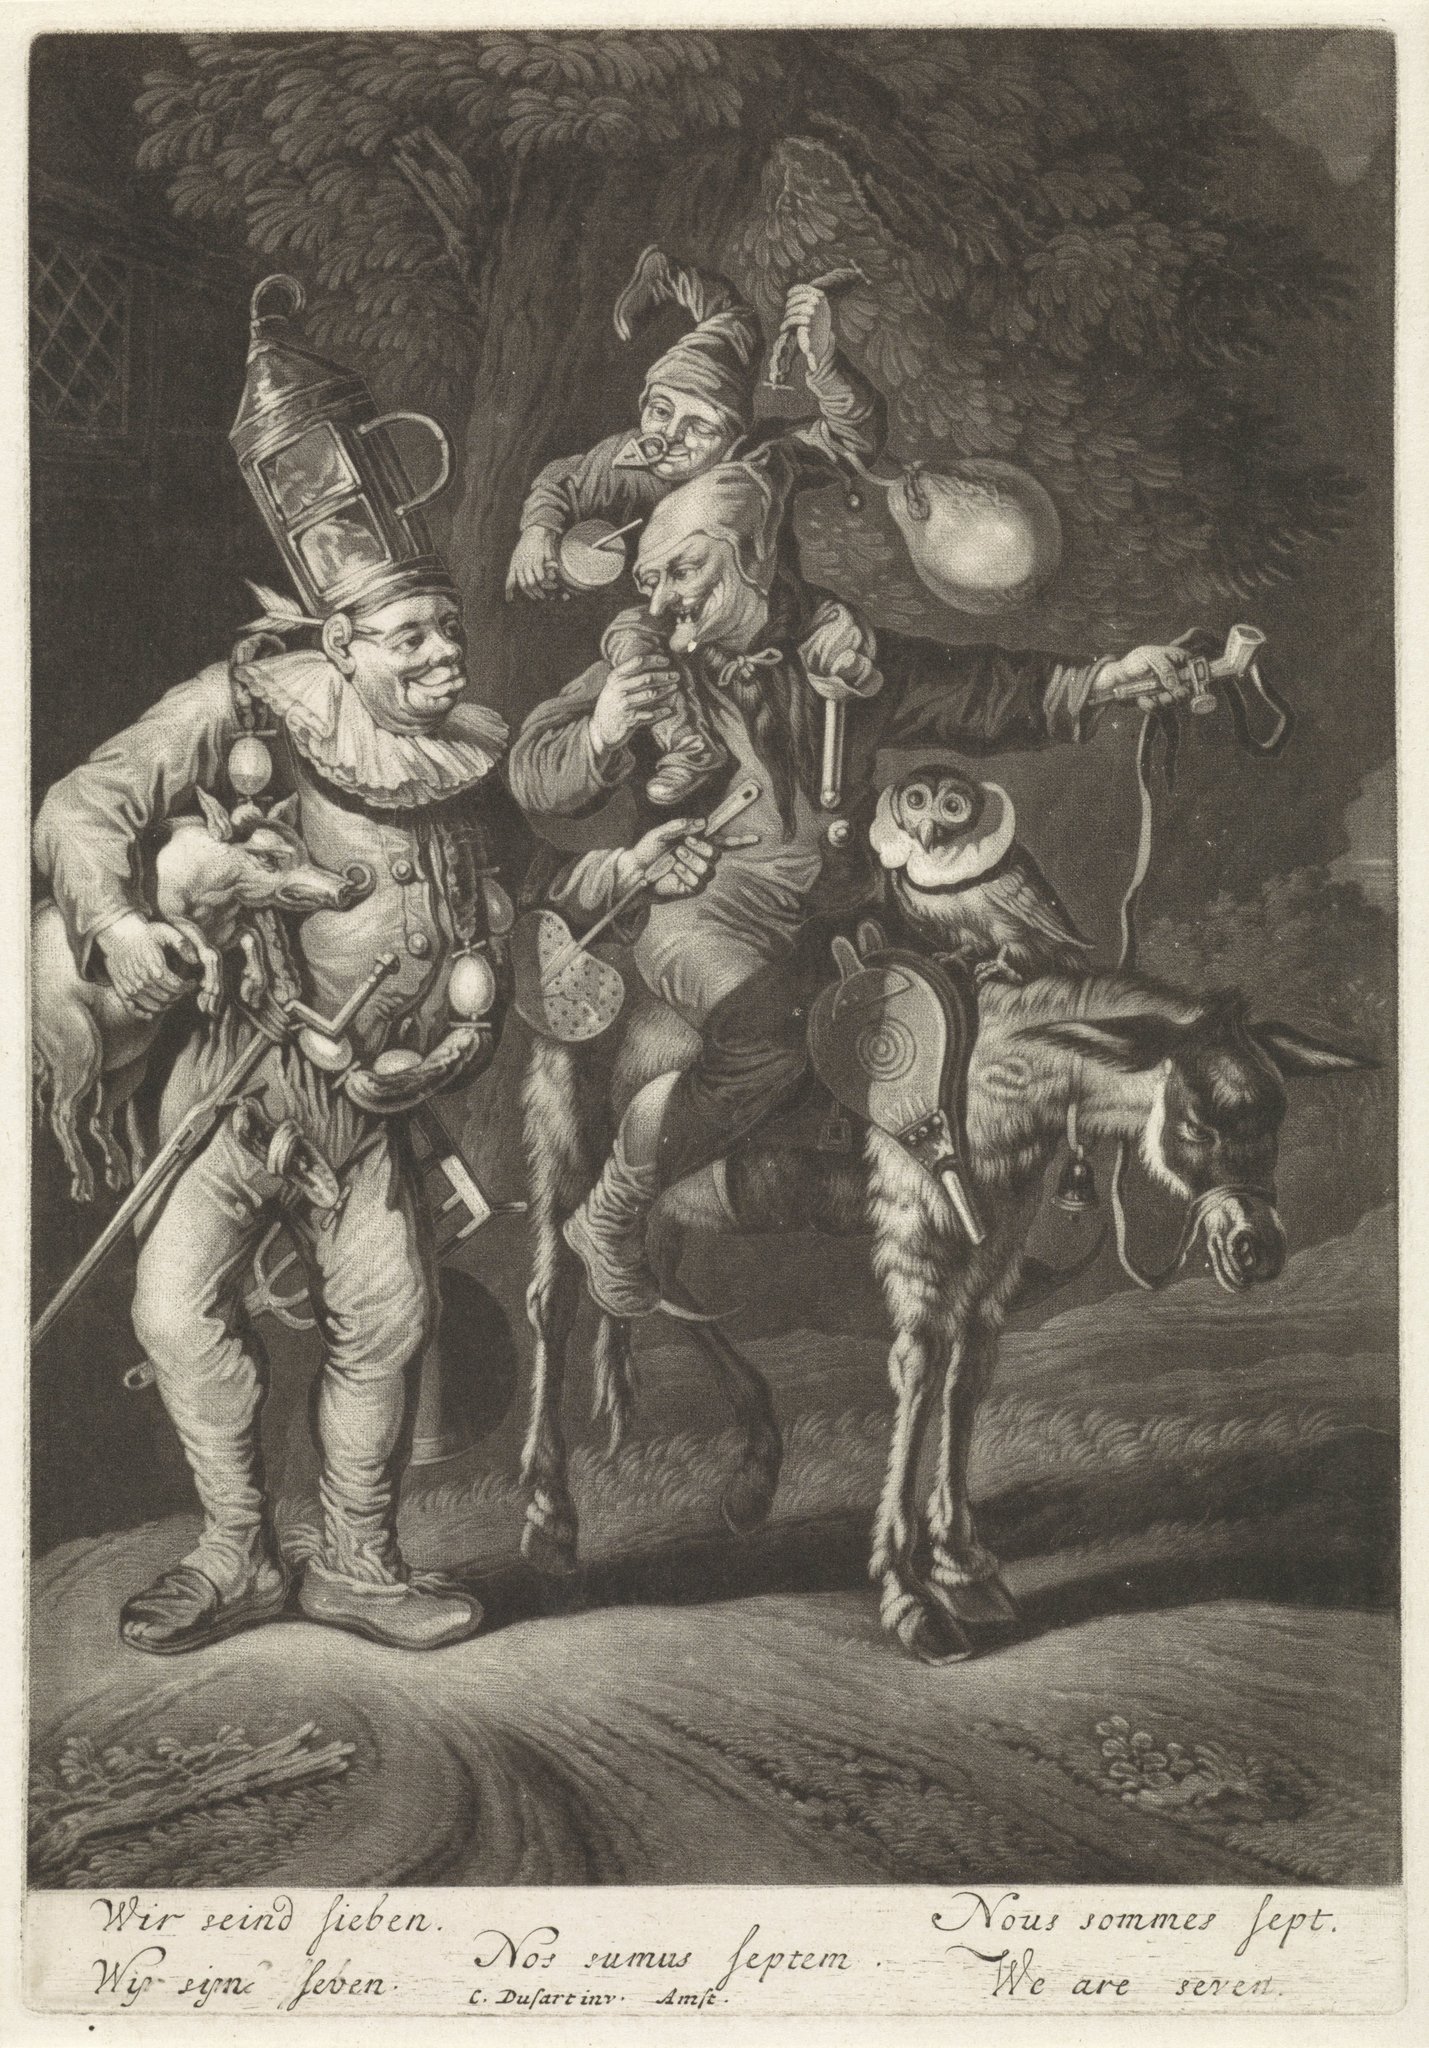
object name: print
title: Wir sind sieben / Nos sumus septem / Nous sommes sept / Wy zyn seven / We are seven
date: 1695-1754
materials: paper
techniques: engraving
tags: pig, ass, donkey, fool, simpleton, numskull, attributes of minerva: owl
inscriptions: collector's mark: Lugt 240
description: Drie mensen en drie dieren in een groteske opstelling. Een ezel draagt een uil op zijn nek en twee ruiters op zijn rug. De eerste ruiter is een grijnzende man met een narrekap op het hoofd en ouderwetse puntschoenen aan zijn voeten, een pijp in zijn hand. Op zijn schouders zit een kleine man met een schoen als hoed op zijn hoofd en een rommelpot onder zijn arm. Zijn mond is met een slot verzegeld. Naast de ezel staat een dikke dom-lachende man met een lantaarn op zijn hoofd. Om zijn buik hangen worsten en eieren en onder zijn arm draagt hij een varkentje.